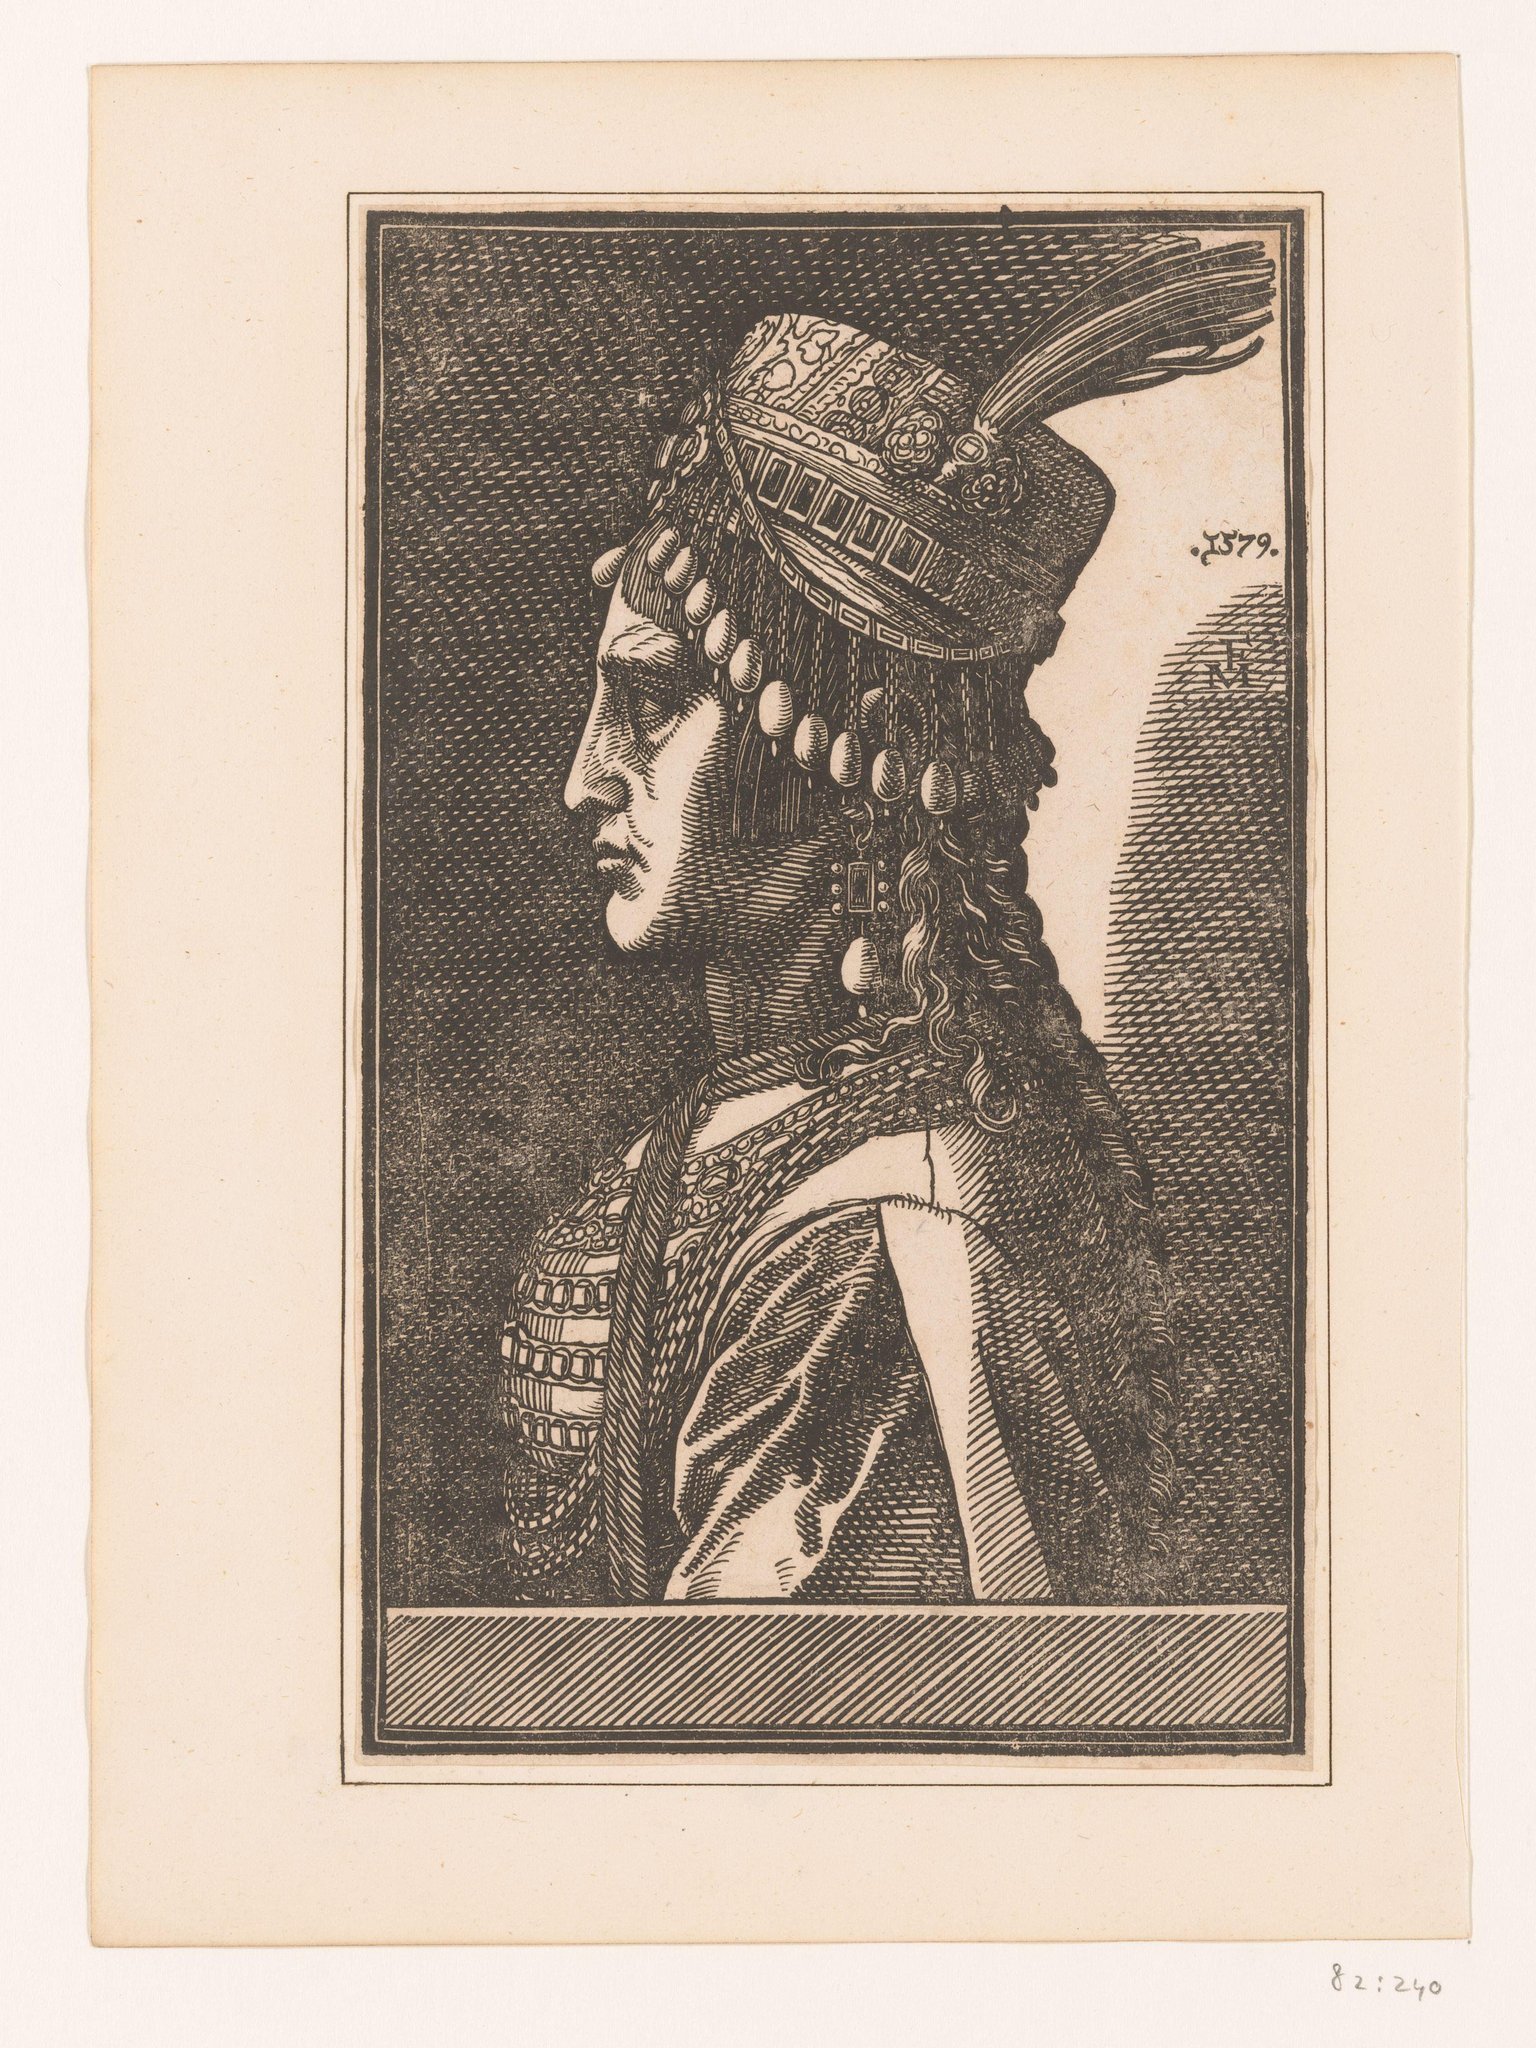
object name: print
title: Portret van een onbekende vrouw van een sultan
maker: melchior lorck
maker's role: draughtsman, painter, print maker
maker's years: 1526-1588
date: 1579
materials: paper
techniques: woodcut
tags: asiatic races and peoples: turks, anonymous historical person portrayed - bb - woman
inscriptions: collector's mark: Lugt 2760, collector's mark: Lugt 2228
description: Uit de editie van 1626 of 1646. Melchior Lorck: Wolgerissene und Geschnittene Figuren, zu Ross und Fuss, sampt schönen Türckischen Gebäwden, und allerhand was in der Türckey zusehen.